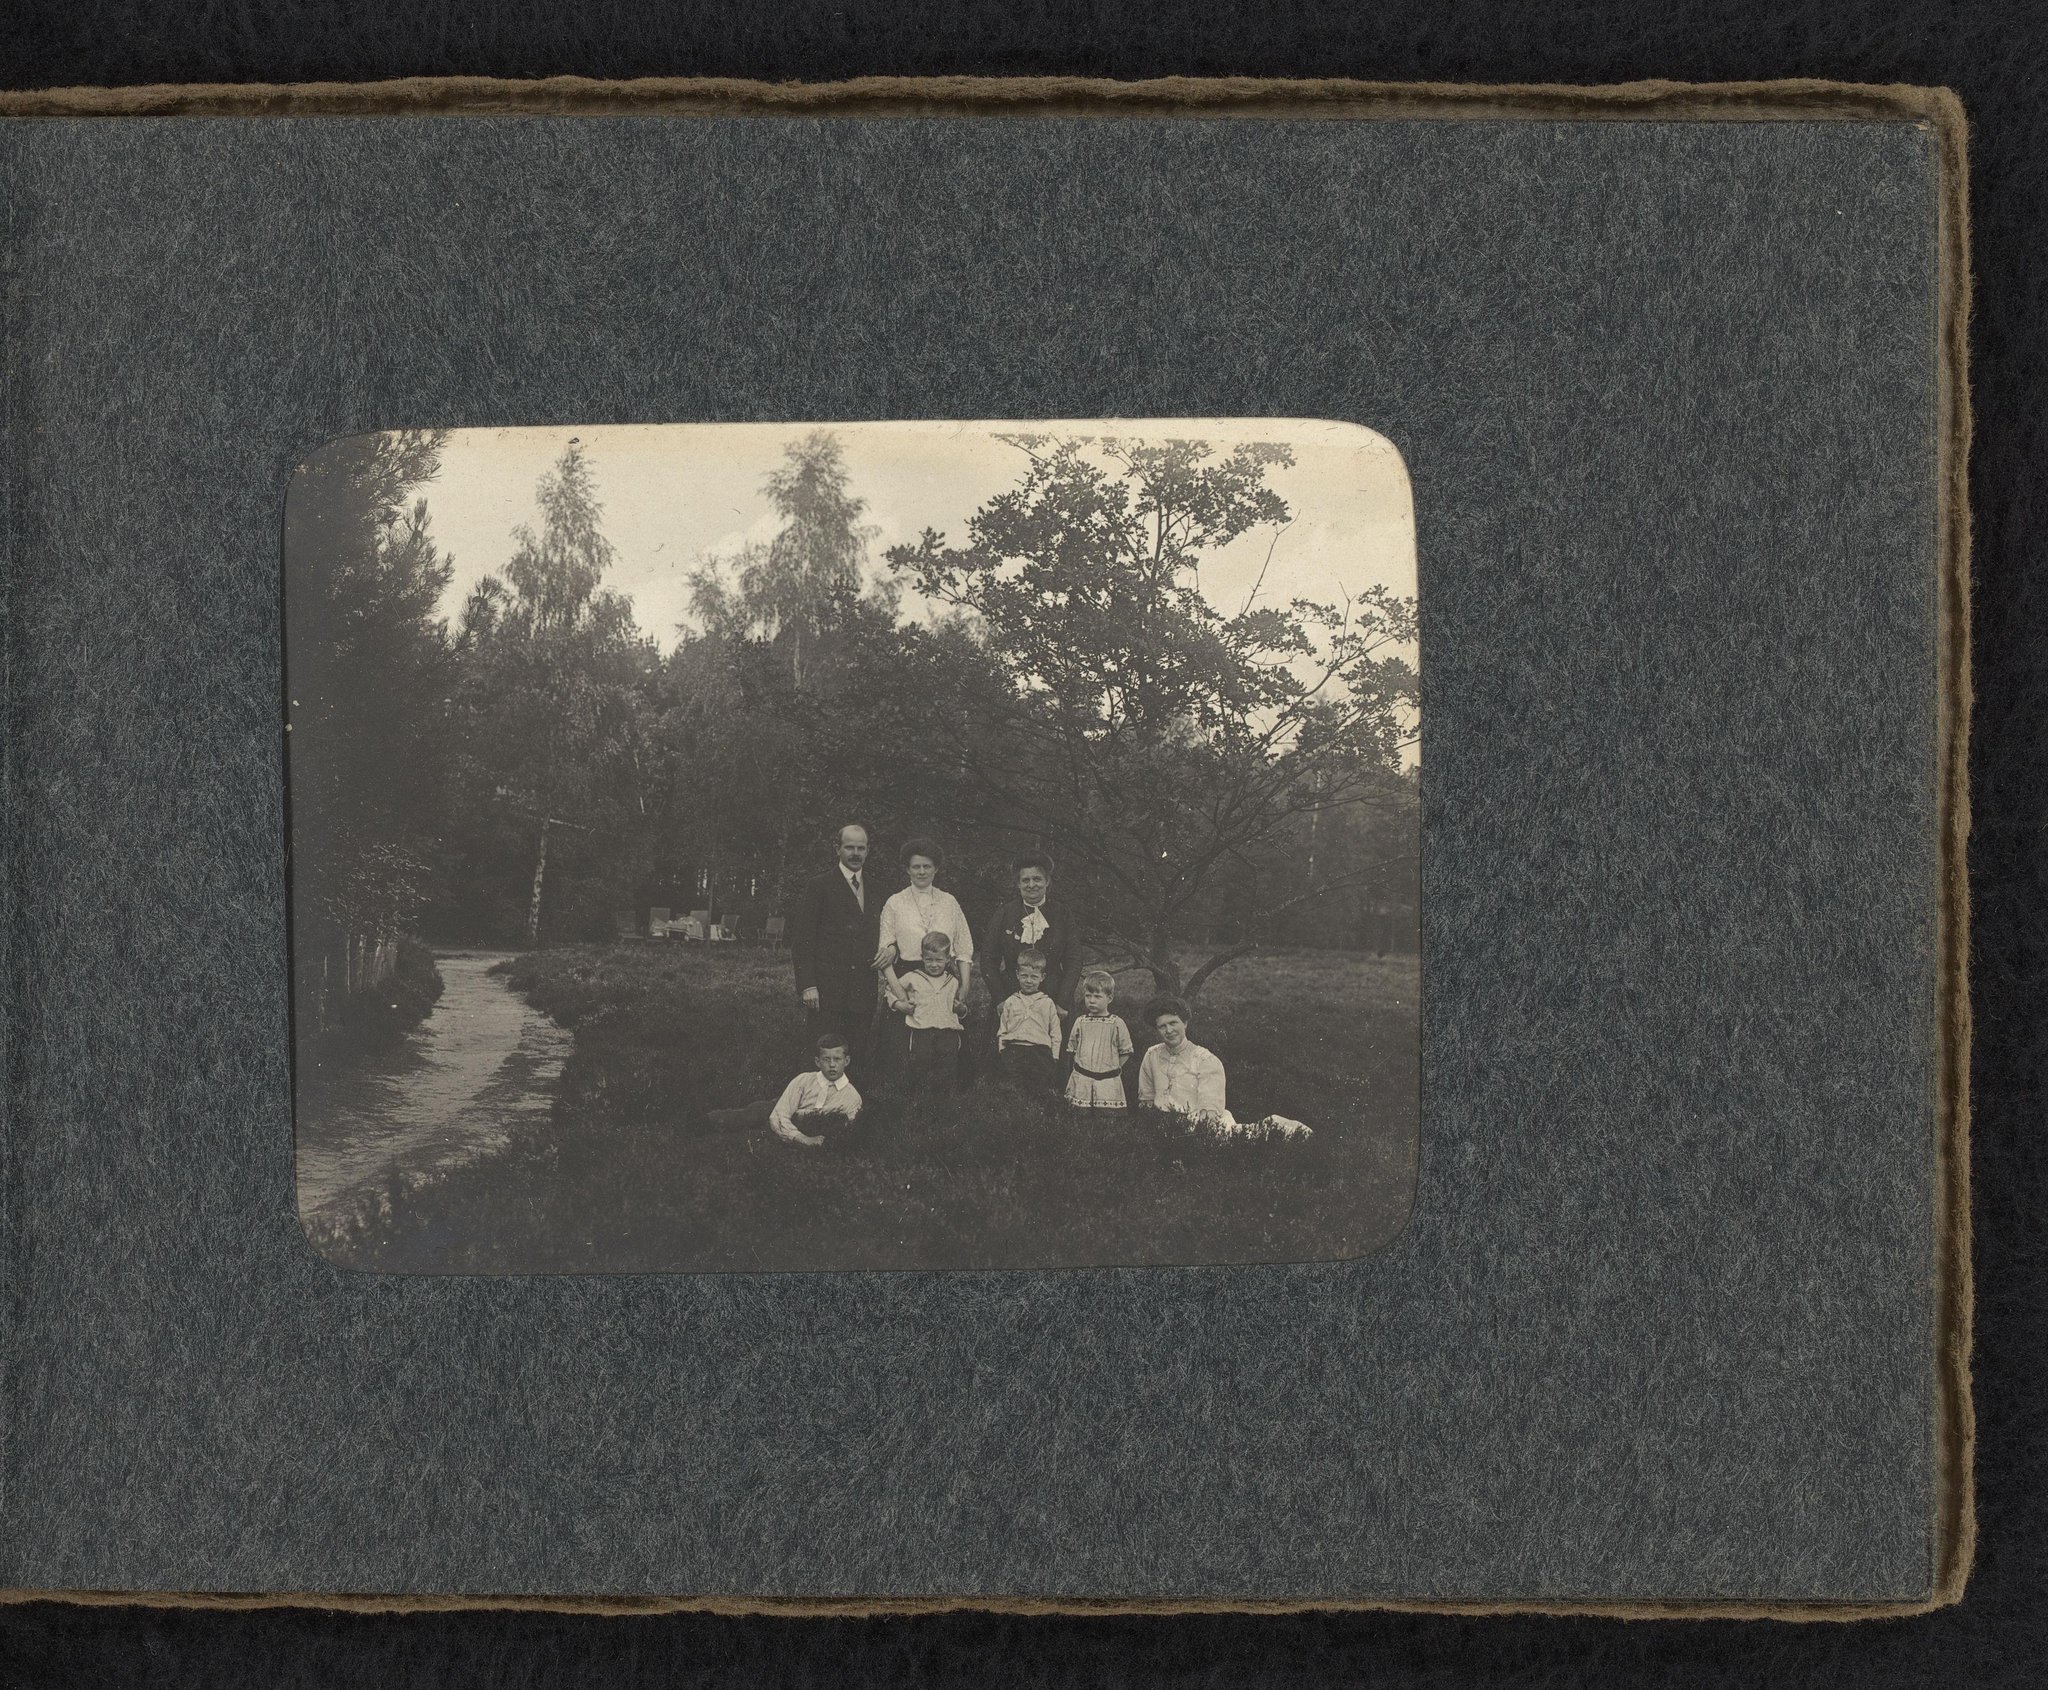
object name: album leaf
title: Familie van den Berg op de heide in Huis ter Heide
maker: hendrik herman van den berg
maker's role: amateurfotograaf, jurist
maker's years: 1875-1944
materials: paper, cardboard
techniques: gelatin silver print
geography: huis ter heide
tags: batavia, amsterdam, hendrik herman van den berg, the hague, caroline louise van den berg-van den berg, family life